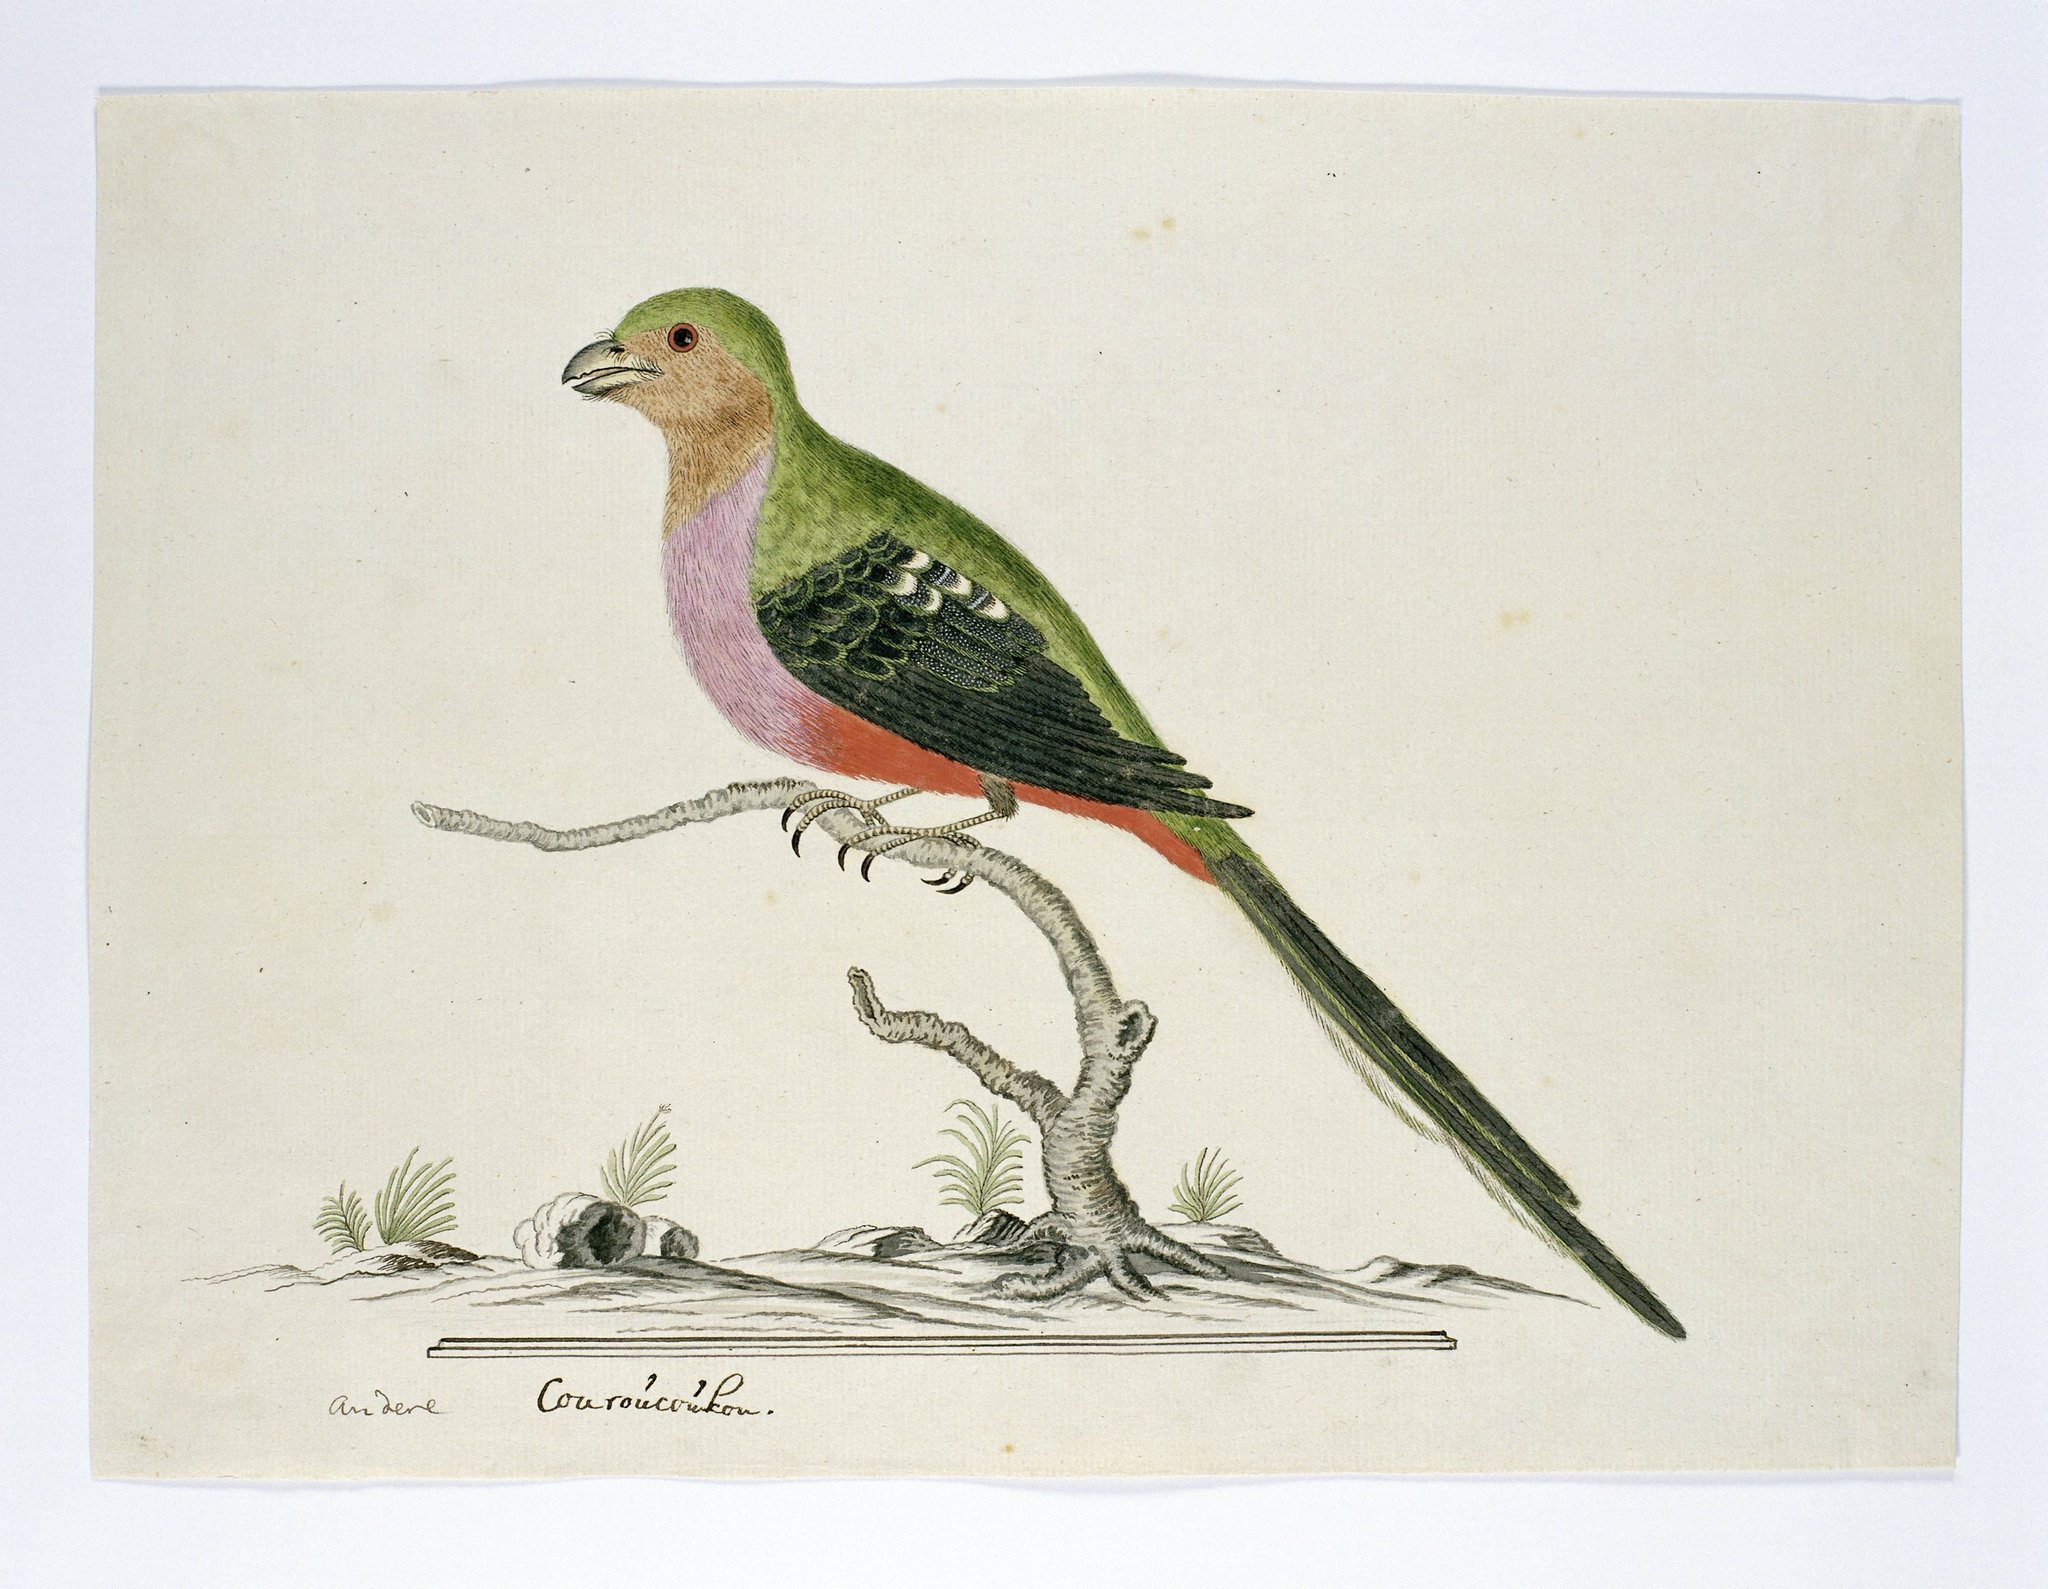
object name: drawing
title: Apaloderma narina (Narina trogon)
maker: robert jacob gordon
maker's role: draughtsman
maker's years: 1743-1795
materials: chalk, paint, ink, paper, pencil, watercolor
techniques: brush, pen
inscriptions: annotation: ‘Andere [spatie] Couroúcoúckou.’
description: Vogelstudie: Bosloerie (Apaloderma narina). Gordon noemt dit een andere couroucouc(k)ou, maar er is slechts één soort in zuidelijk Afrika.